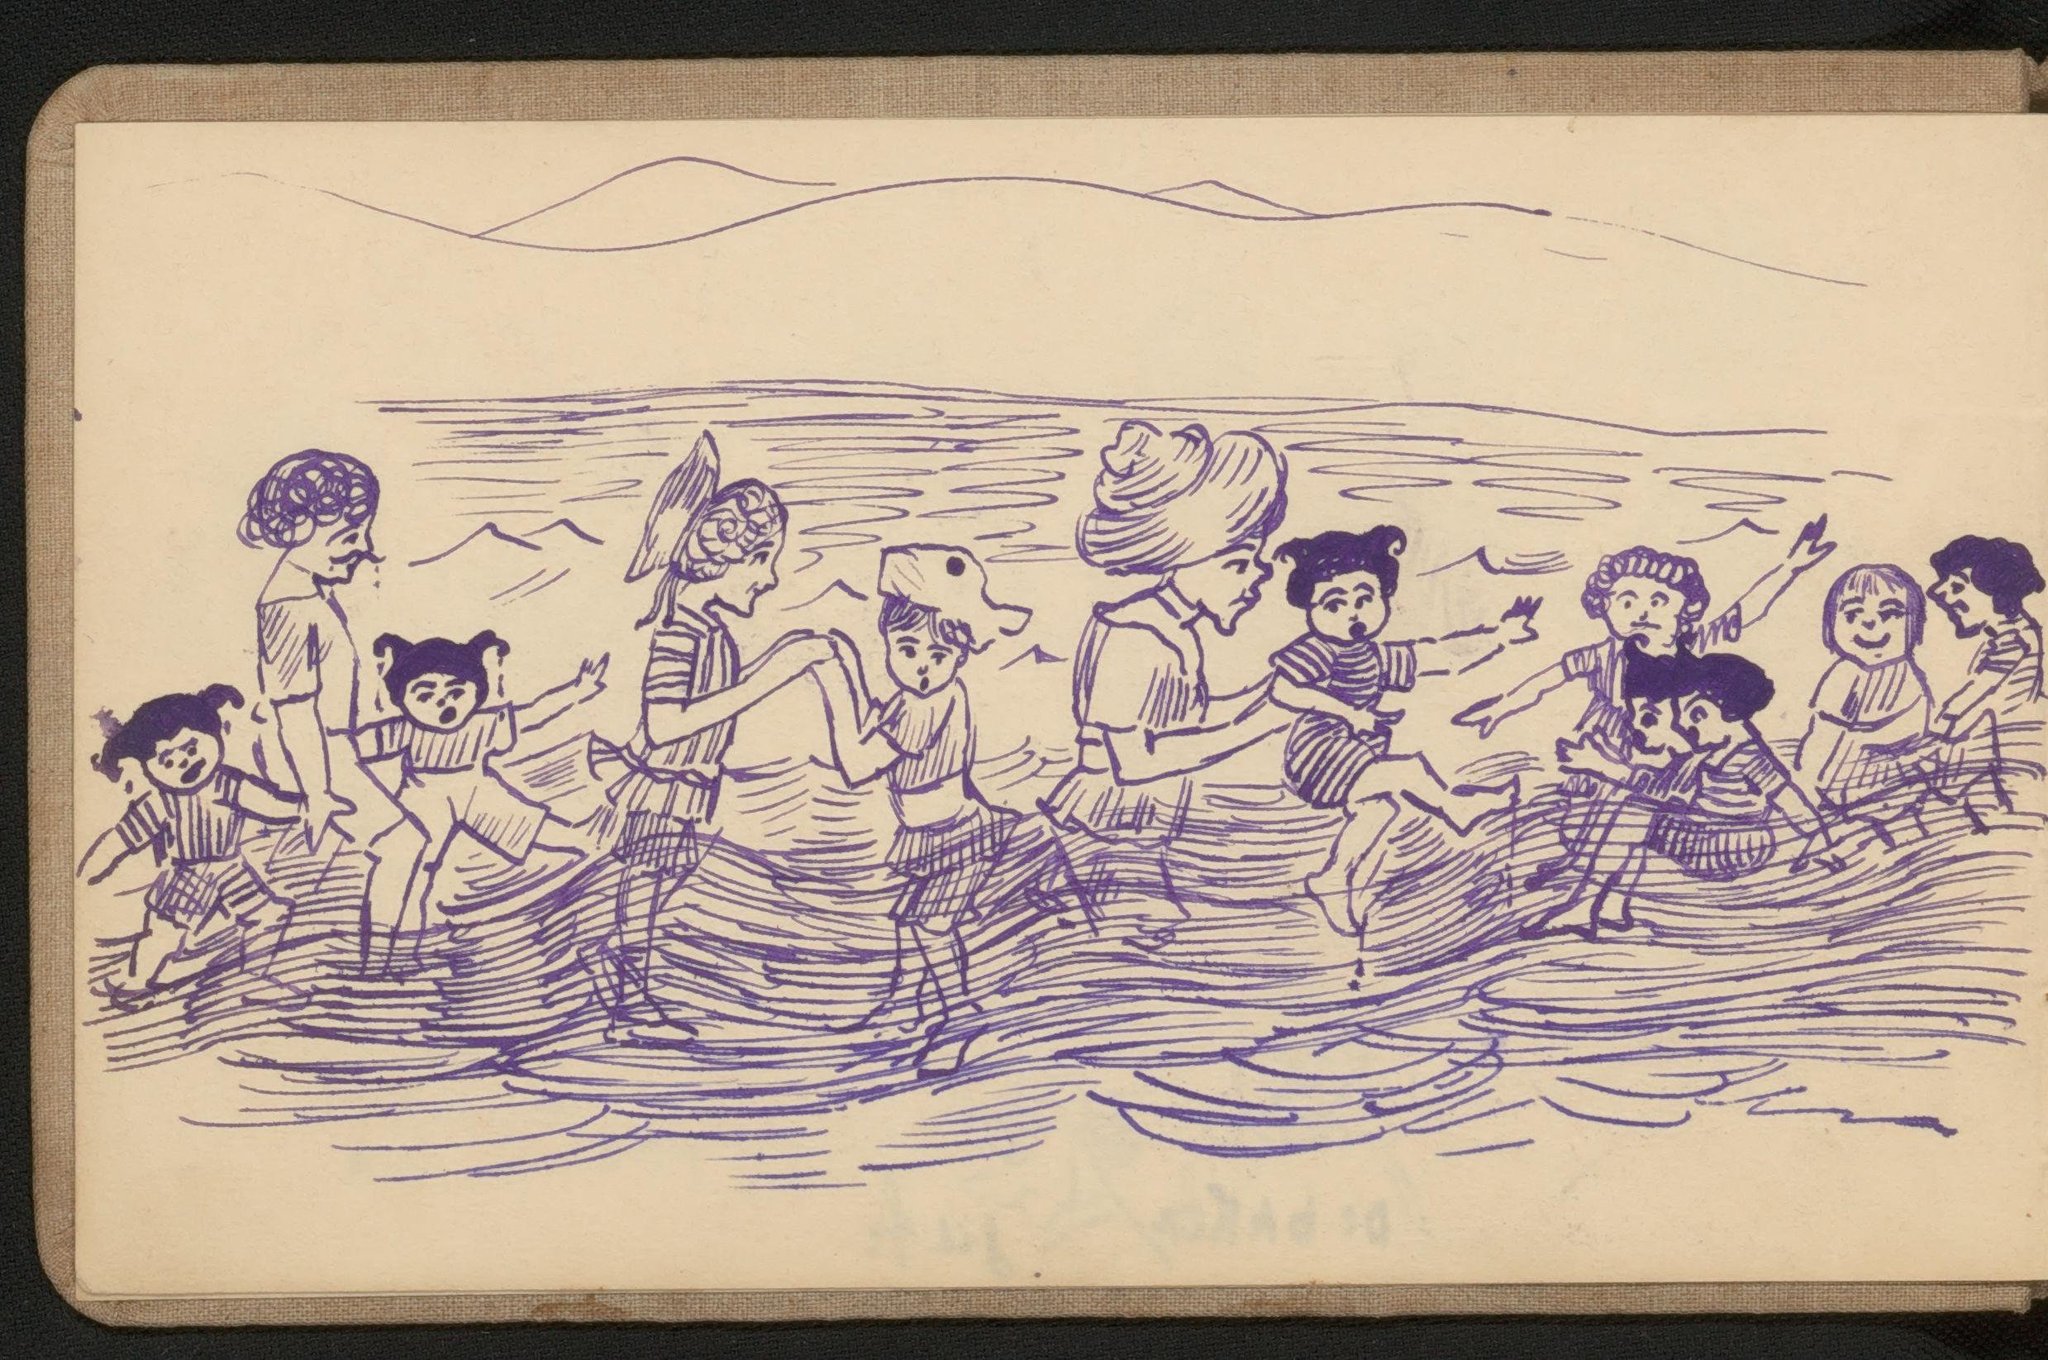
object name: sketchbook leaf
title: Op het strand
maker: Anonymous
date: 1875-1920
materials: ink, paper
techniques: pen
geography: netherlands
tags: beach (as place of recreation), the family travelling, on holiday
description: Het hele gezin op het strand, sommigen in het water, de ouders in strandstoelen. Doorlopende voorstelling op pagina 1 verso en pagina 2 recto. Onderdeel van het schetsboek met humoristische tekeningen over het leven van een 'famille nombreuse'. Onderwerpsrubrieken binnen de Atlas Zeden en Gewoonten: Zeden en Gewoonten in Engeren Zin, Des menschen beging, midden en einde, Kinderleven.